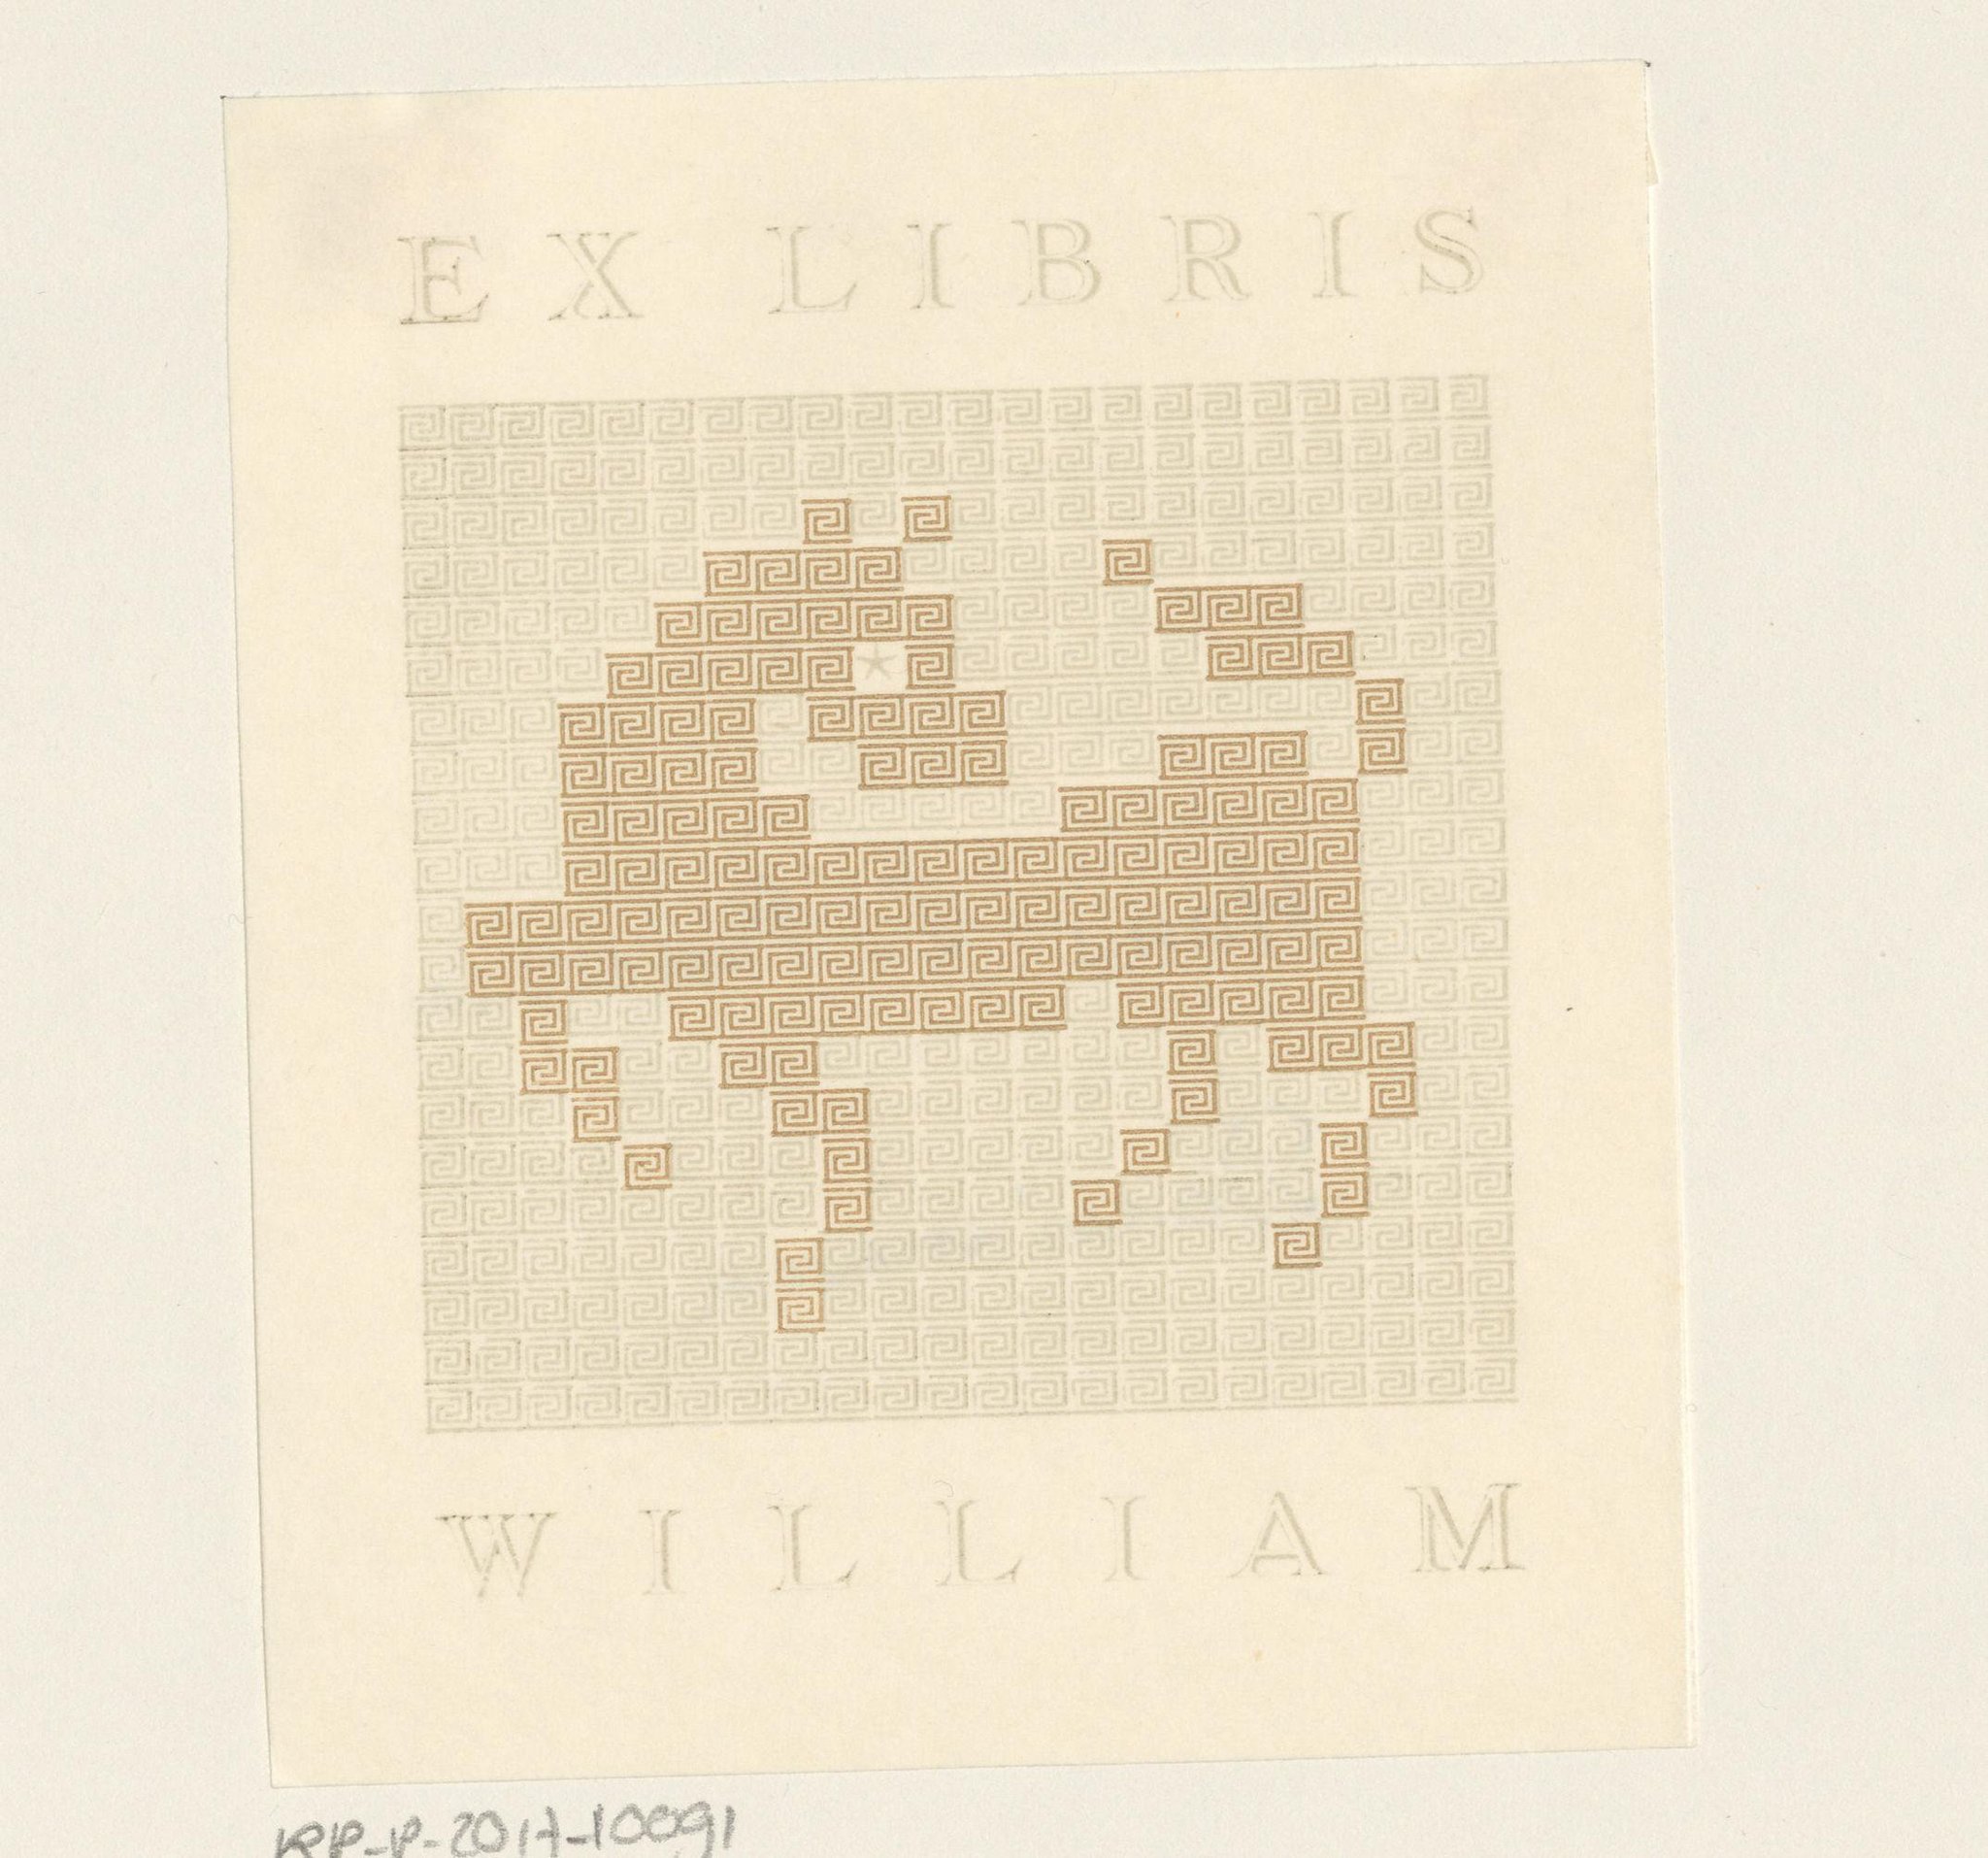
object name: bookplate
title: Ex libris van William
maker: Anonymous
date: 1950-1999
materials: paper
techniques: printing block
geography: denmark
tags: mammals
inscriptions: inscription: ‘Hans J. Pedersen/ Danimarca’